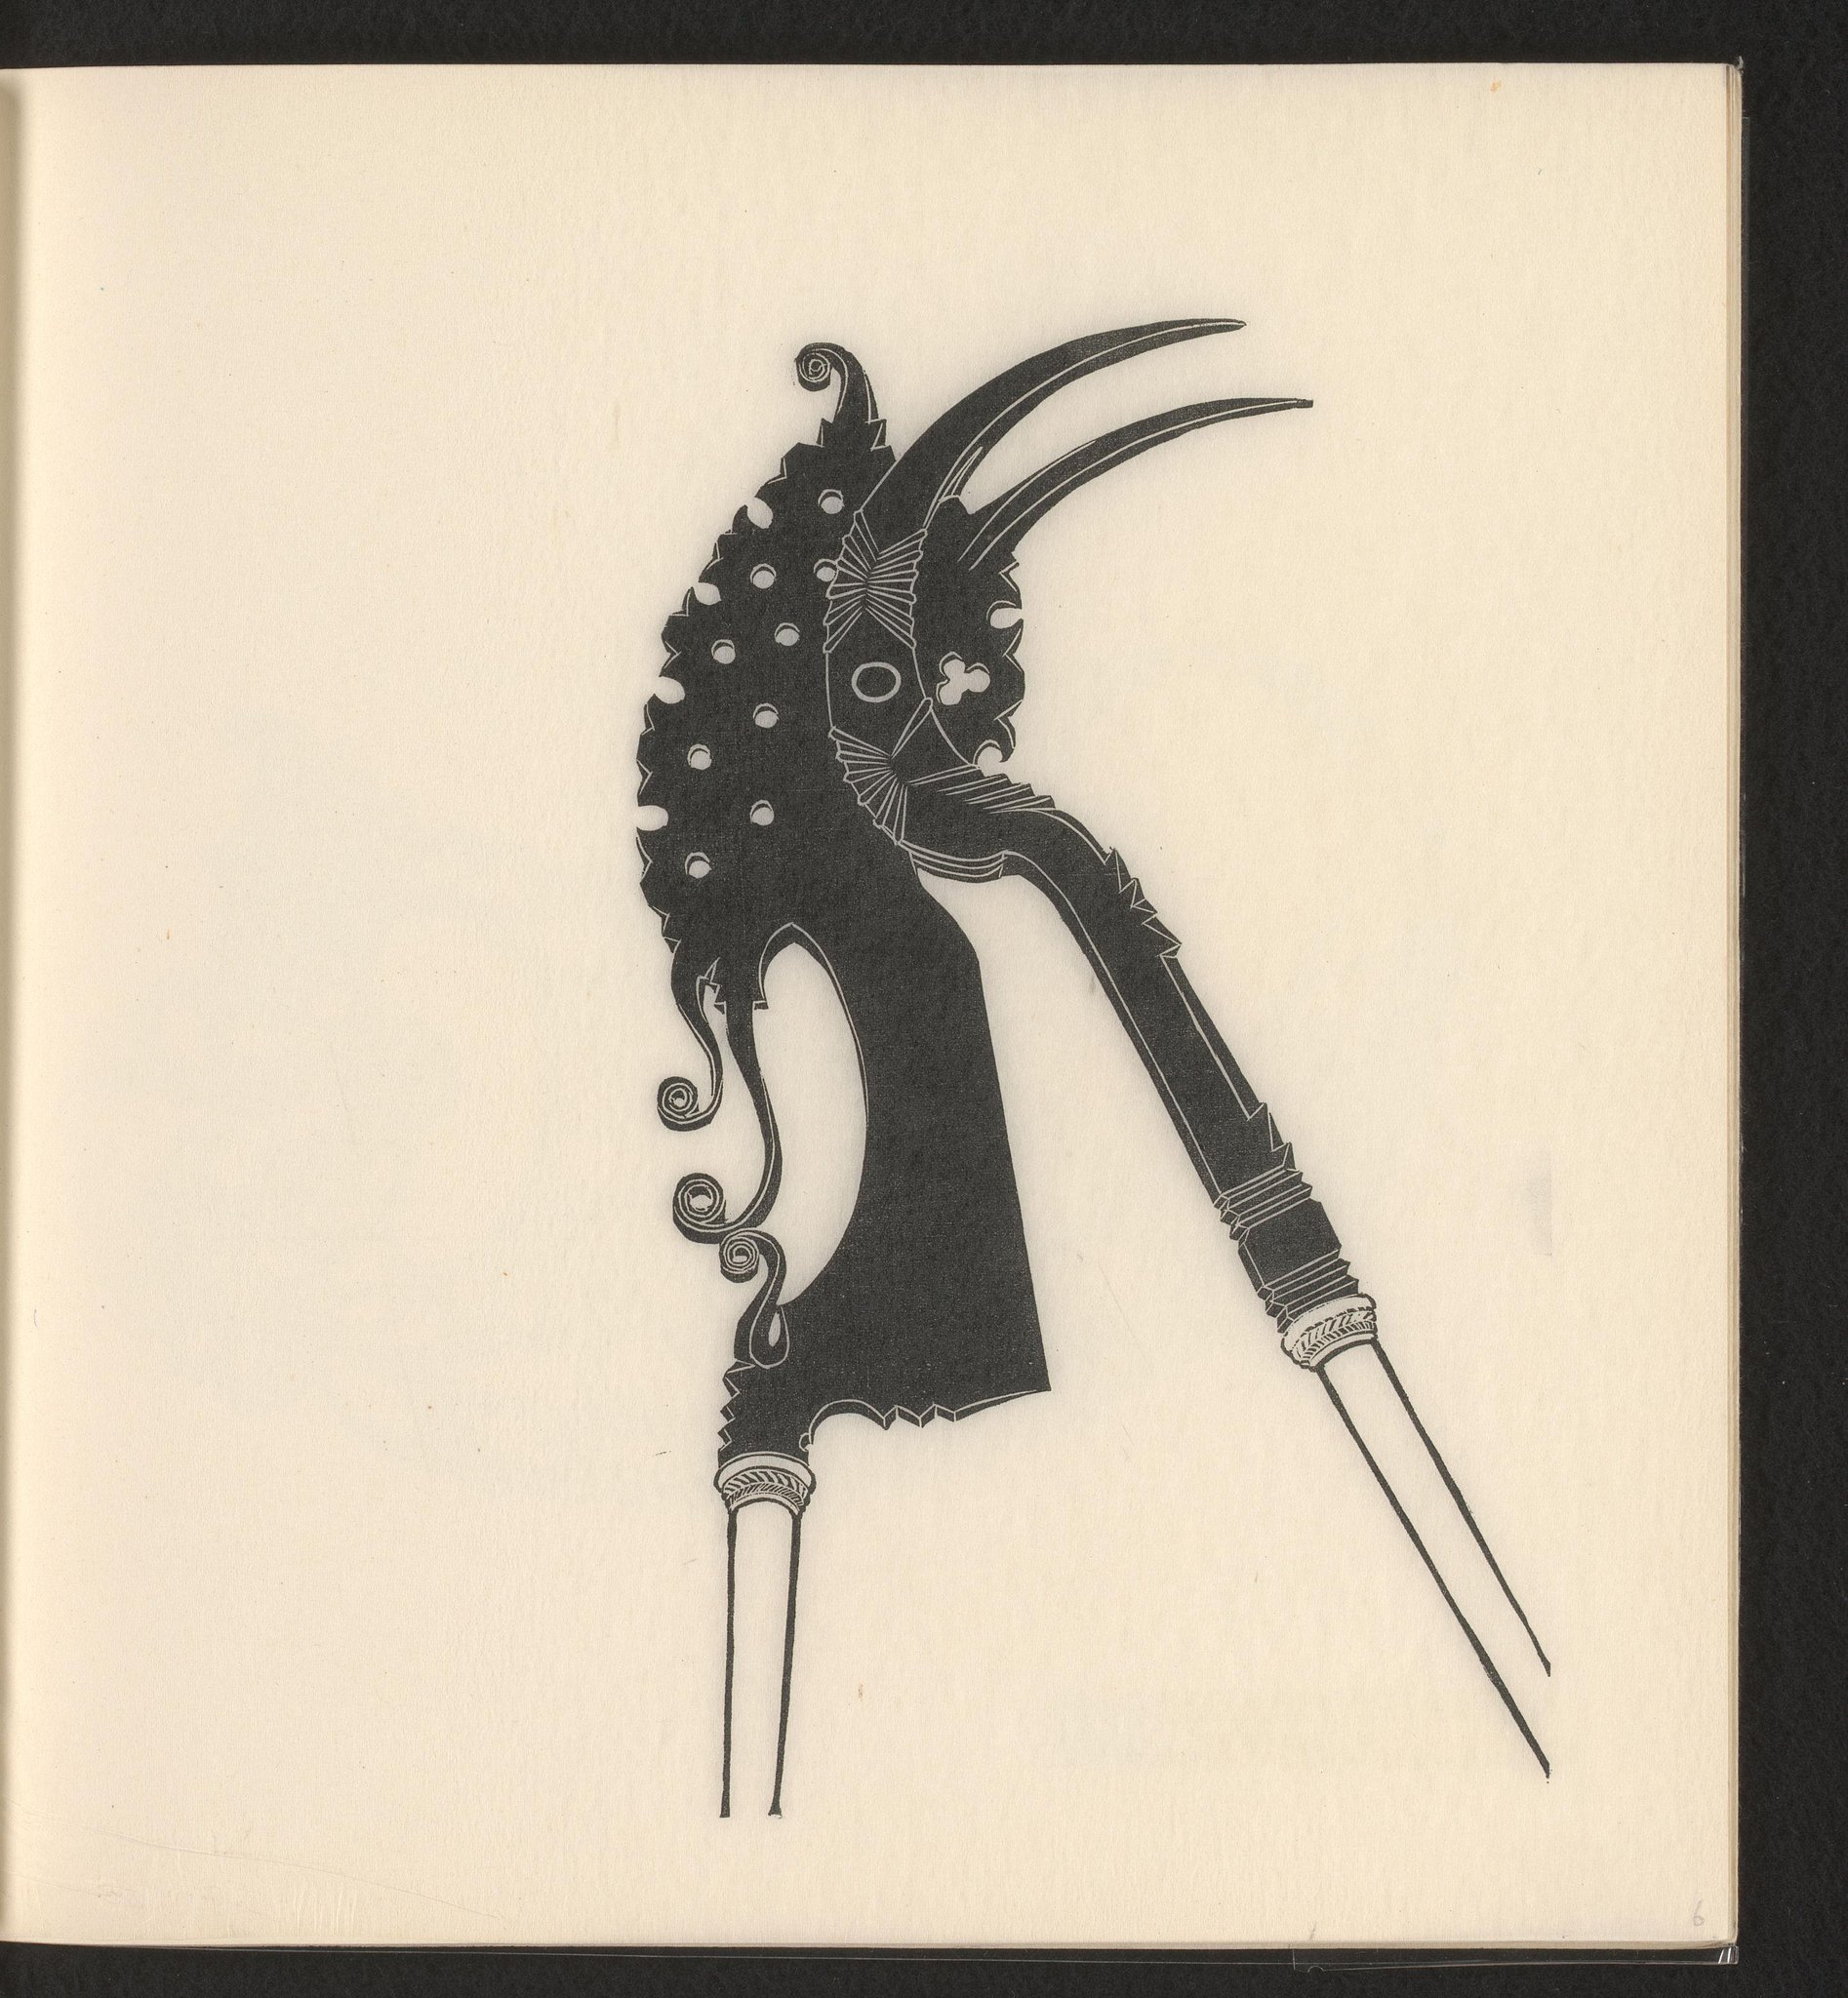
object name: print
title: Pinangschaar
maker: reijer stolk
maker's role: draughtsman, print maker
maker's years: 1896-1945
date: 1942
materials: paper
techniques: woodcut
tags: tools, aids, implements ~ crafts and industries: scissors, indonesia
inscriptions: date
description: Pinangschaar in de vorm van een neushoornvogel. Onderdeel van album 'Tien bladen sierkunst uit ons Oost-Indië'.